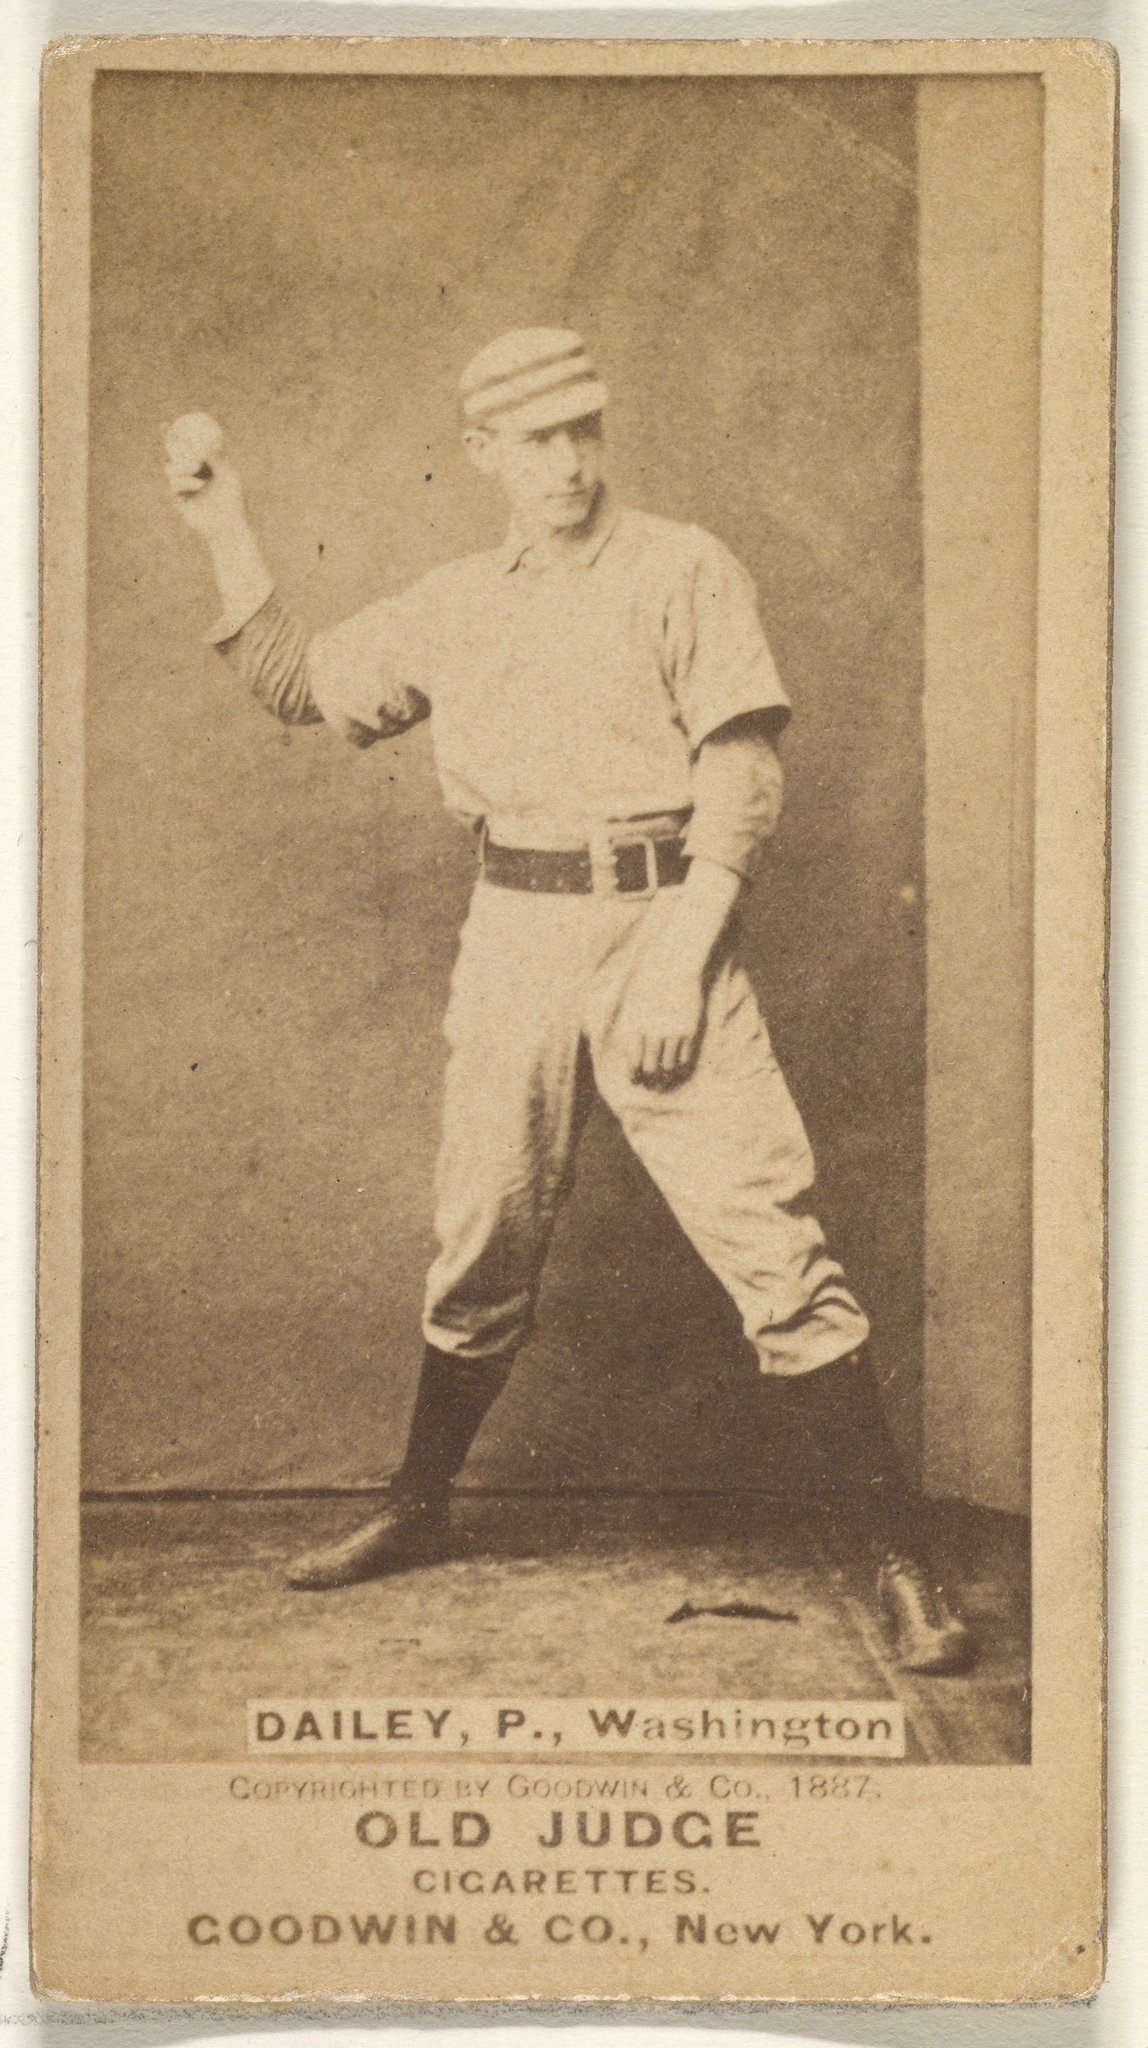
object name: baseball card, photograph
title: Edward M. Daily, Pitcher, Washington Nationals, from the Old Judge series (N172) for Old Judge Cigarettes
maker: goodwin & company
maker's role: publisher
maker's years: 1850-1950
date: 1887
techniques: albumen silver print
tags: men,portraits,baseball,athletes